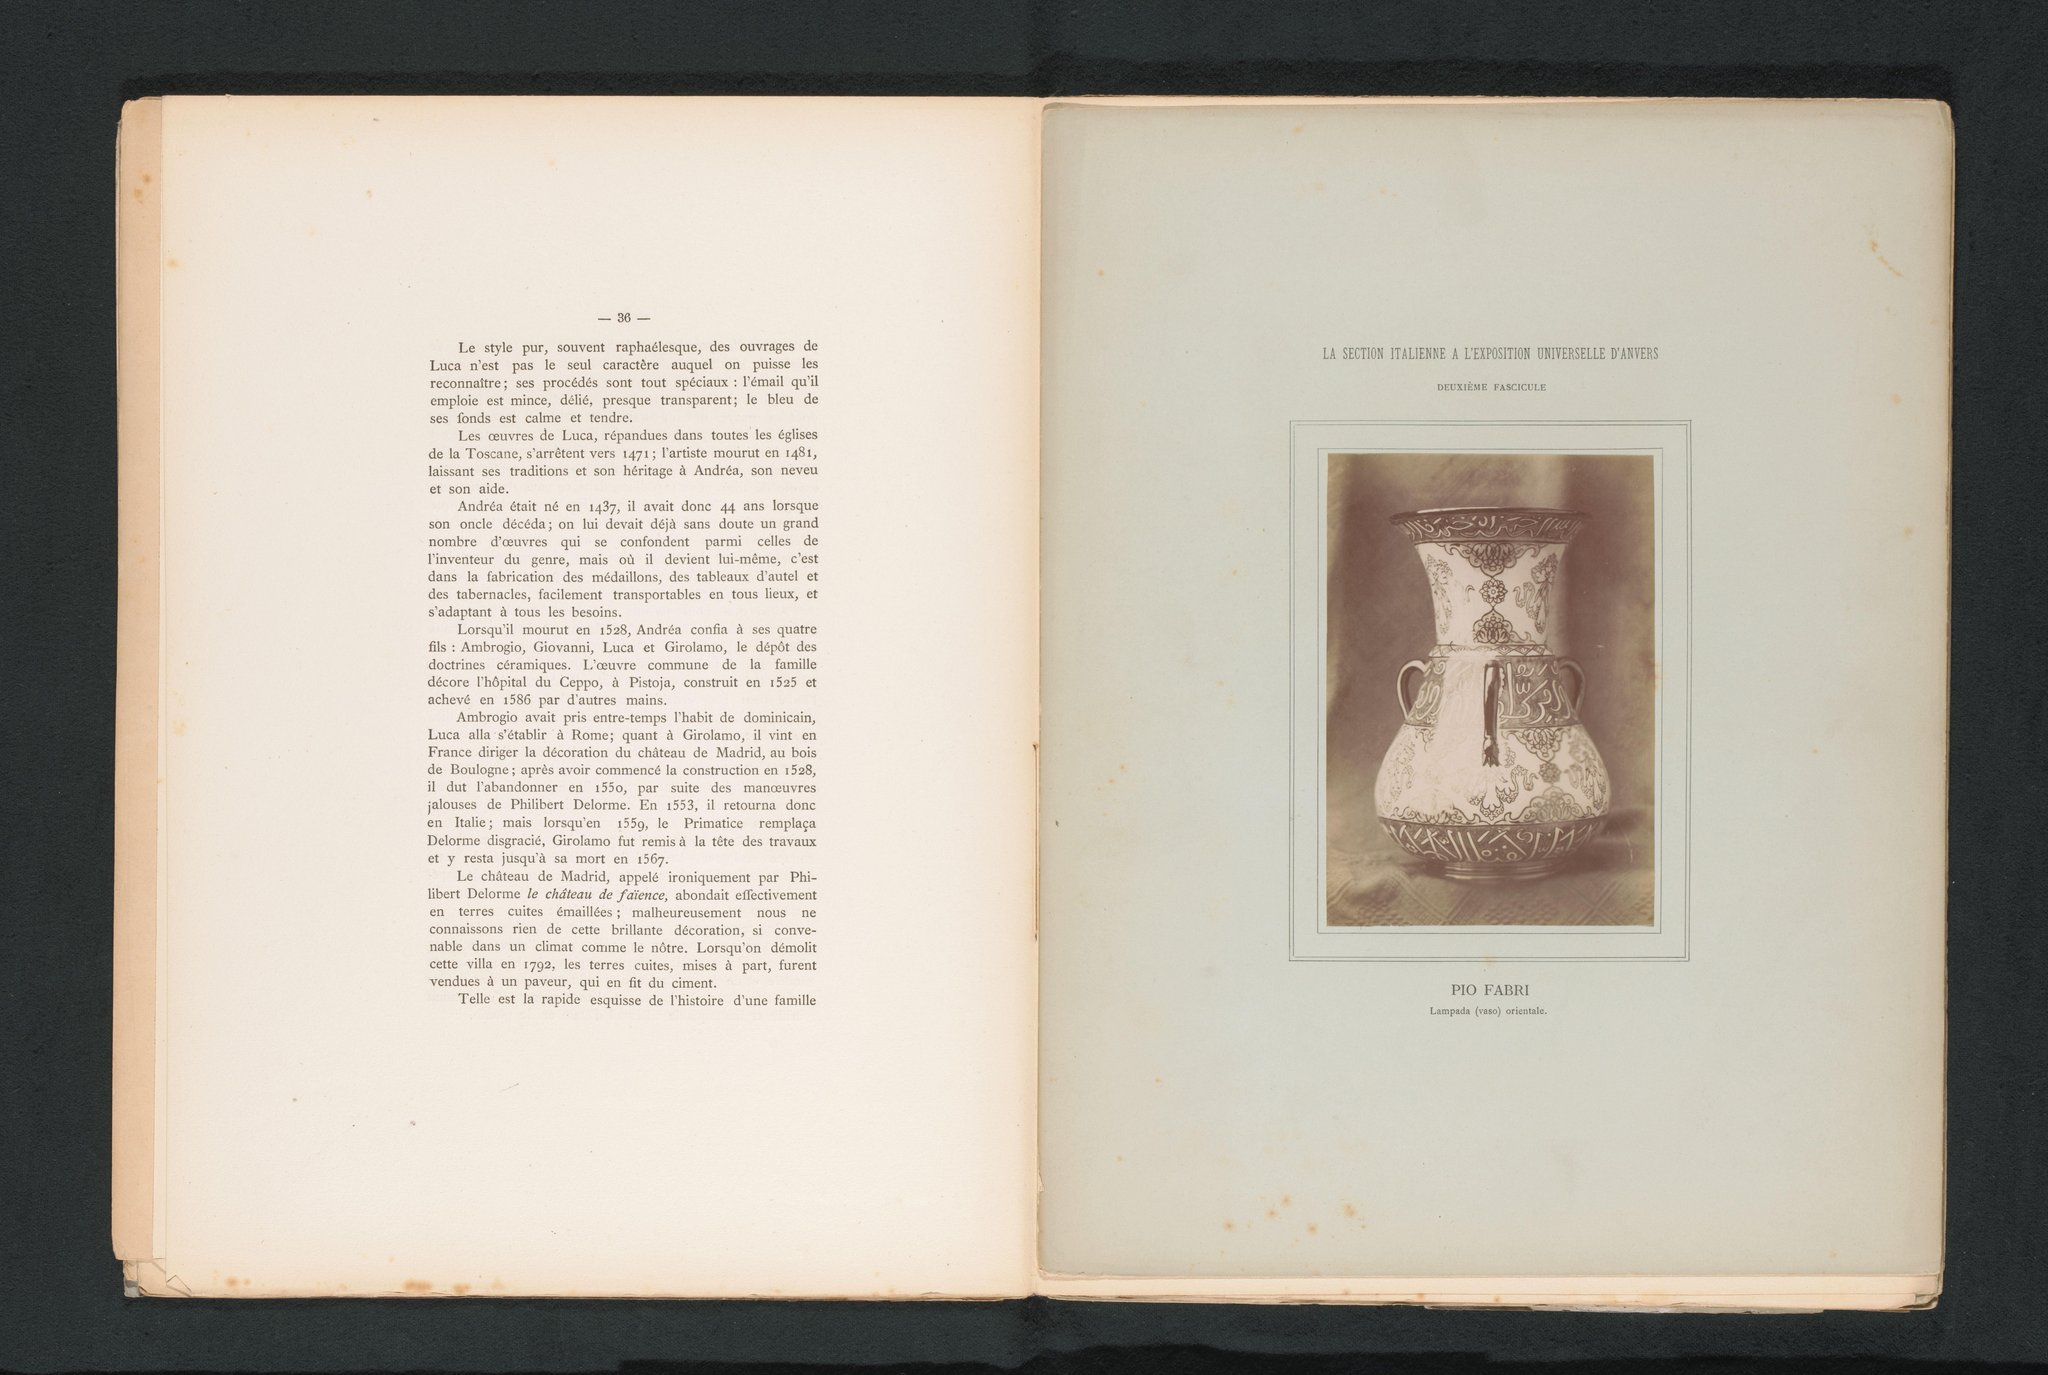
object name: page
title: La Section Italienne a l'Exposition Universelle d'Anvers - Deuxième Fascicule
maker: Anonymous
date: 1880-1885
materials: photographic support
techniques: albumen print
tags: container of ceramics: jar, jug, pot, vase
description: Foto op losse plaat tegenover pagina 36.